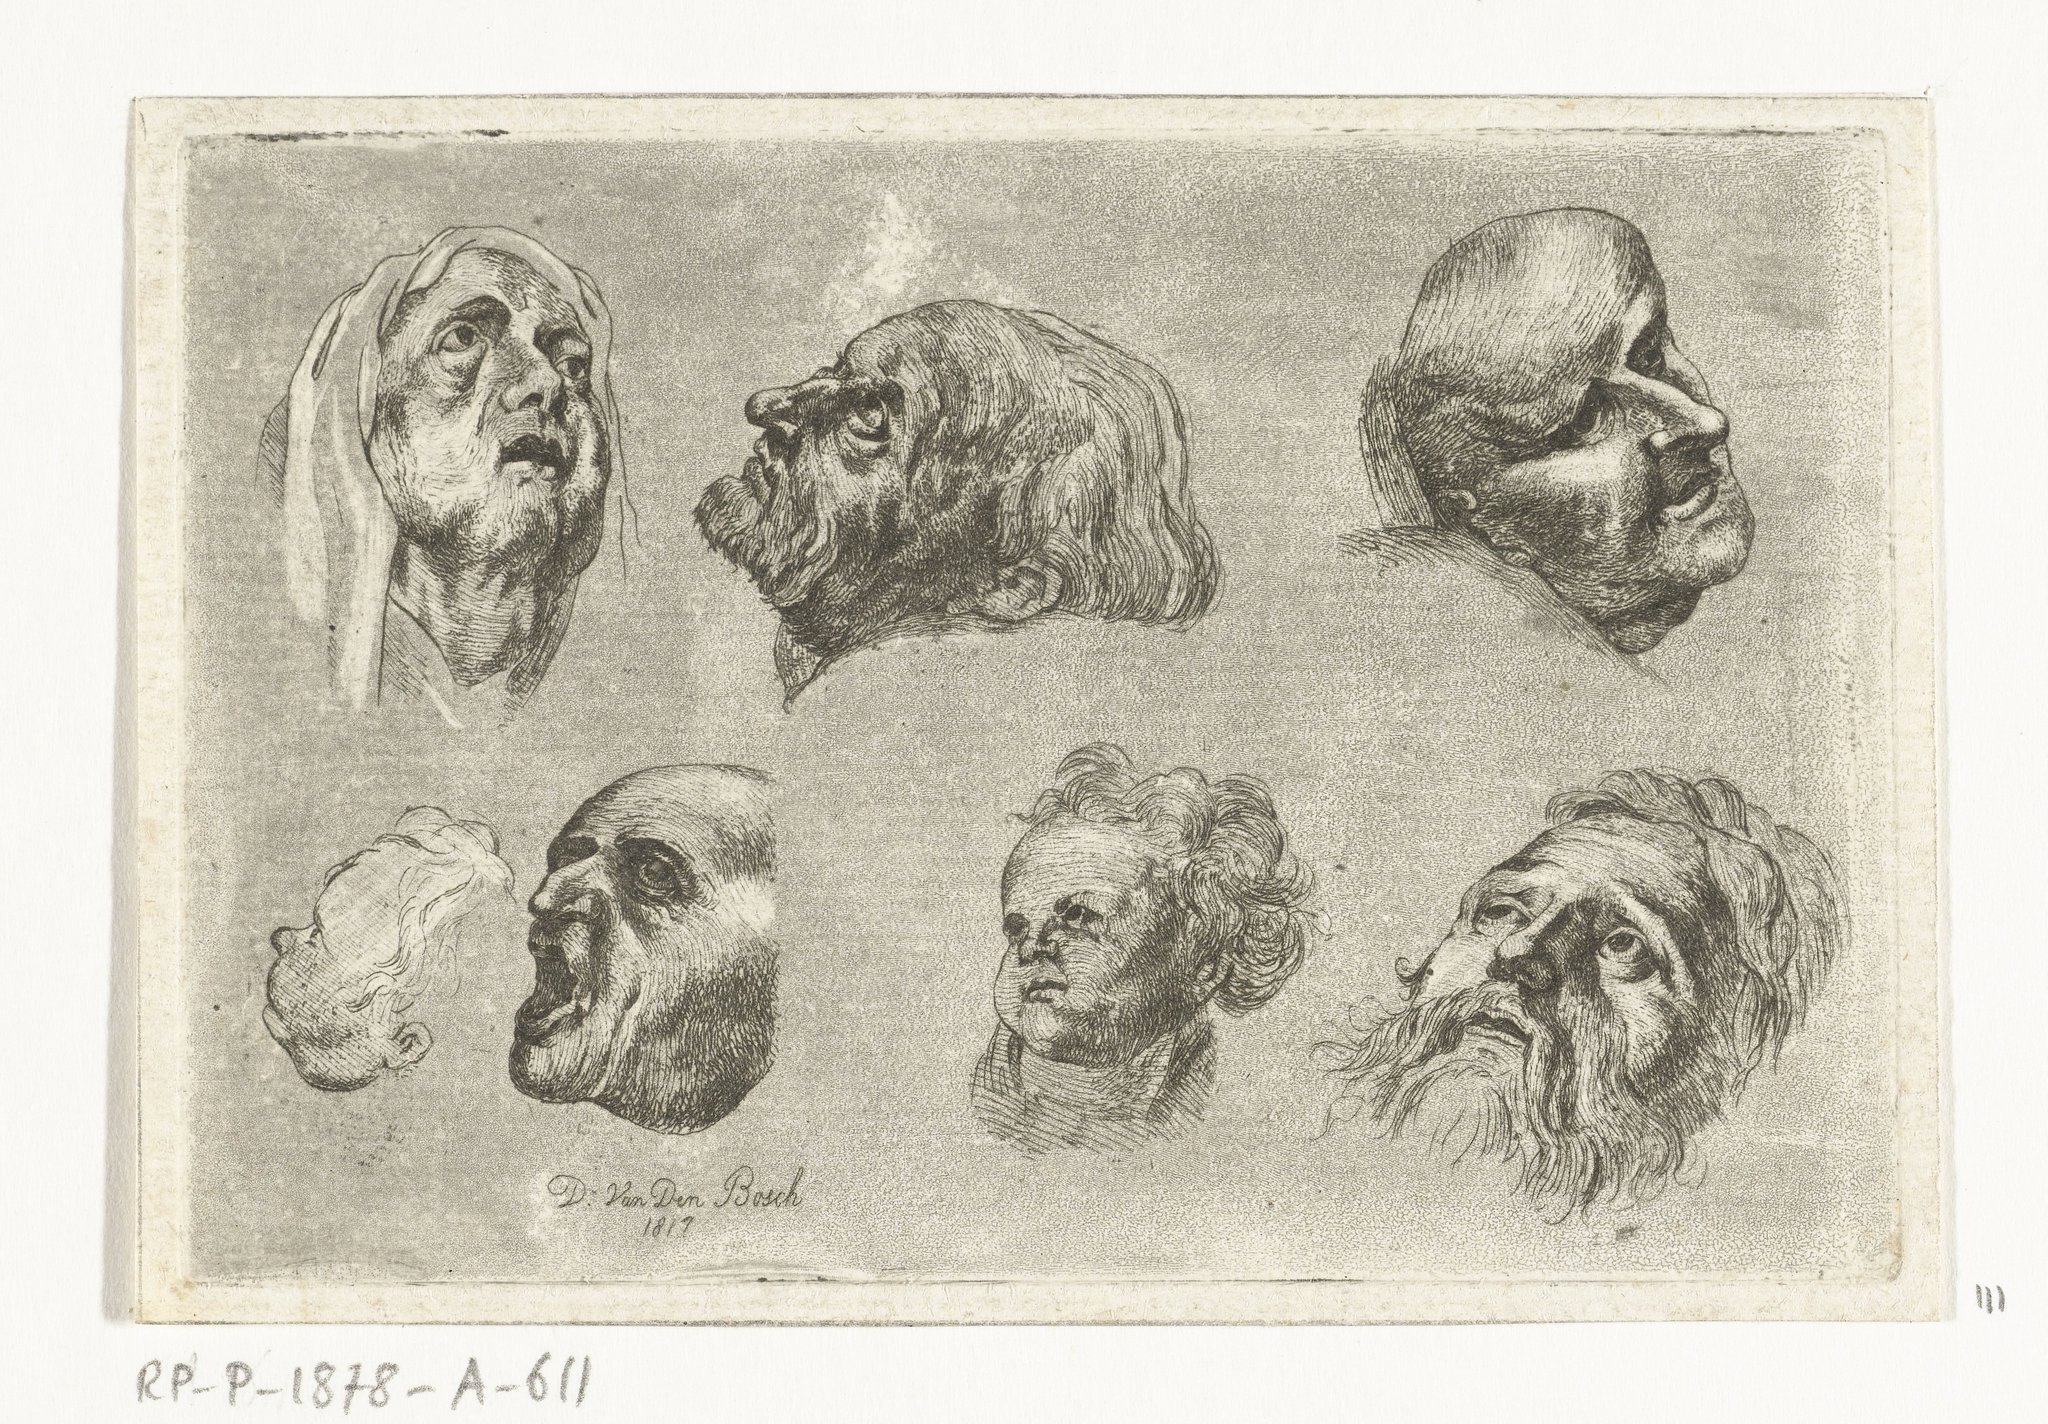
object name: print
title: Studieblad met zeven hoofden in twee rijen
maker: d. van den bosch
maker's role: print maker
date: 1817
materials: paper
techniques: aquatint, etching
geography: netherlands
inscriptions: collector's mark: Lugt 2227